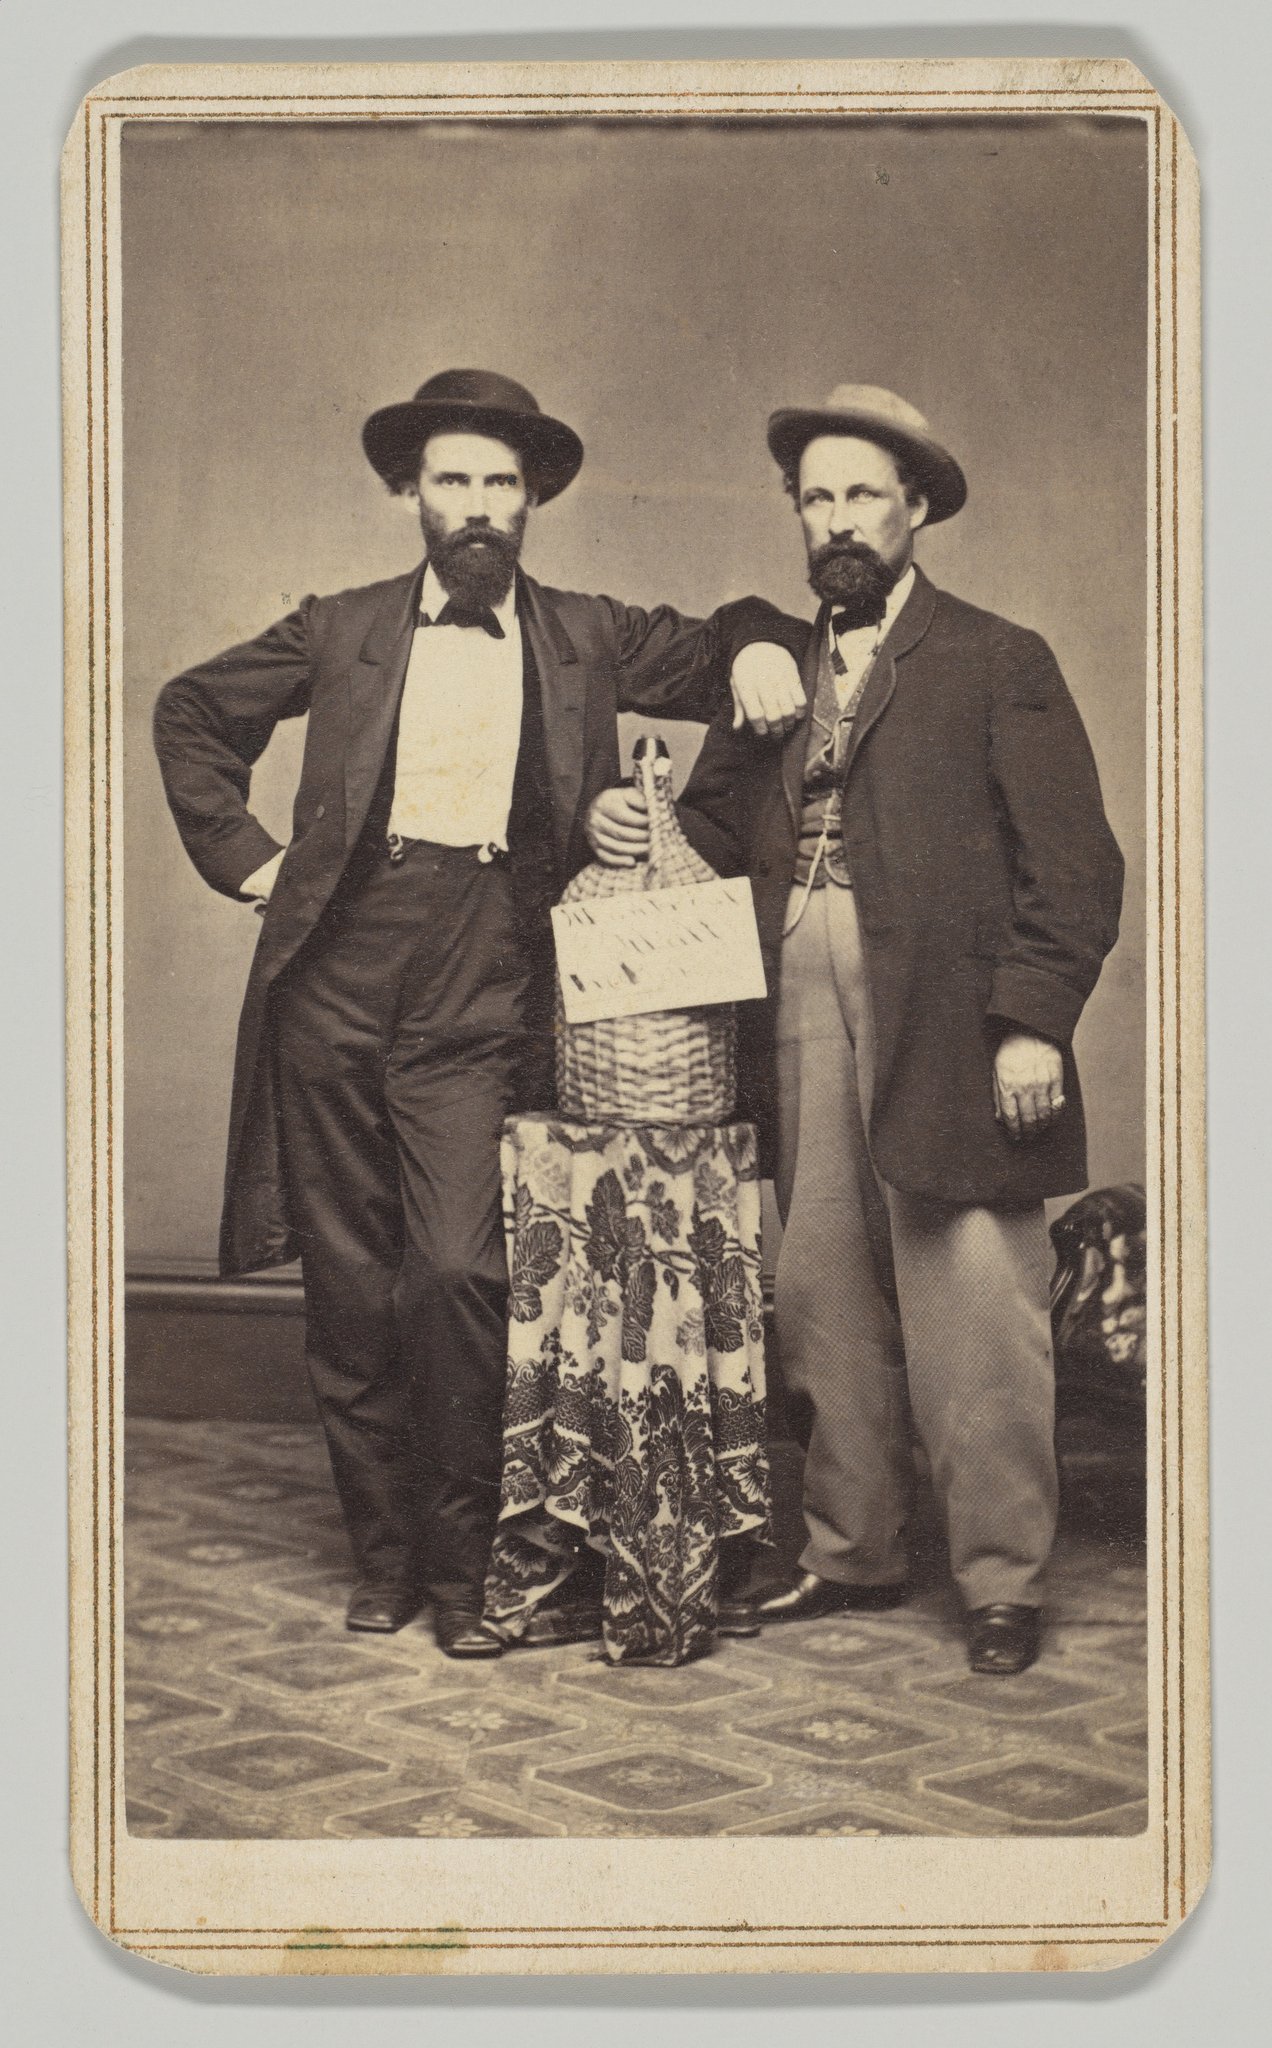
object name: photograph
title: [Two Wine Merchants with Cask]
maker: moore brothers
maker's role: artist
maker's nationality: american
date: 1860-1869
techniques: albumen silver print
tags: men,portraits